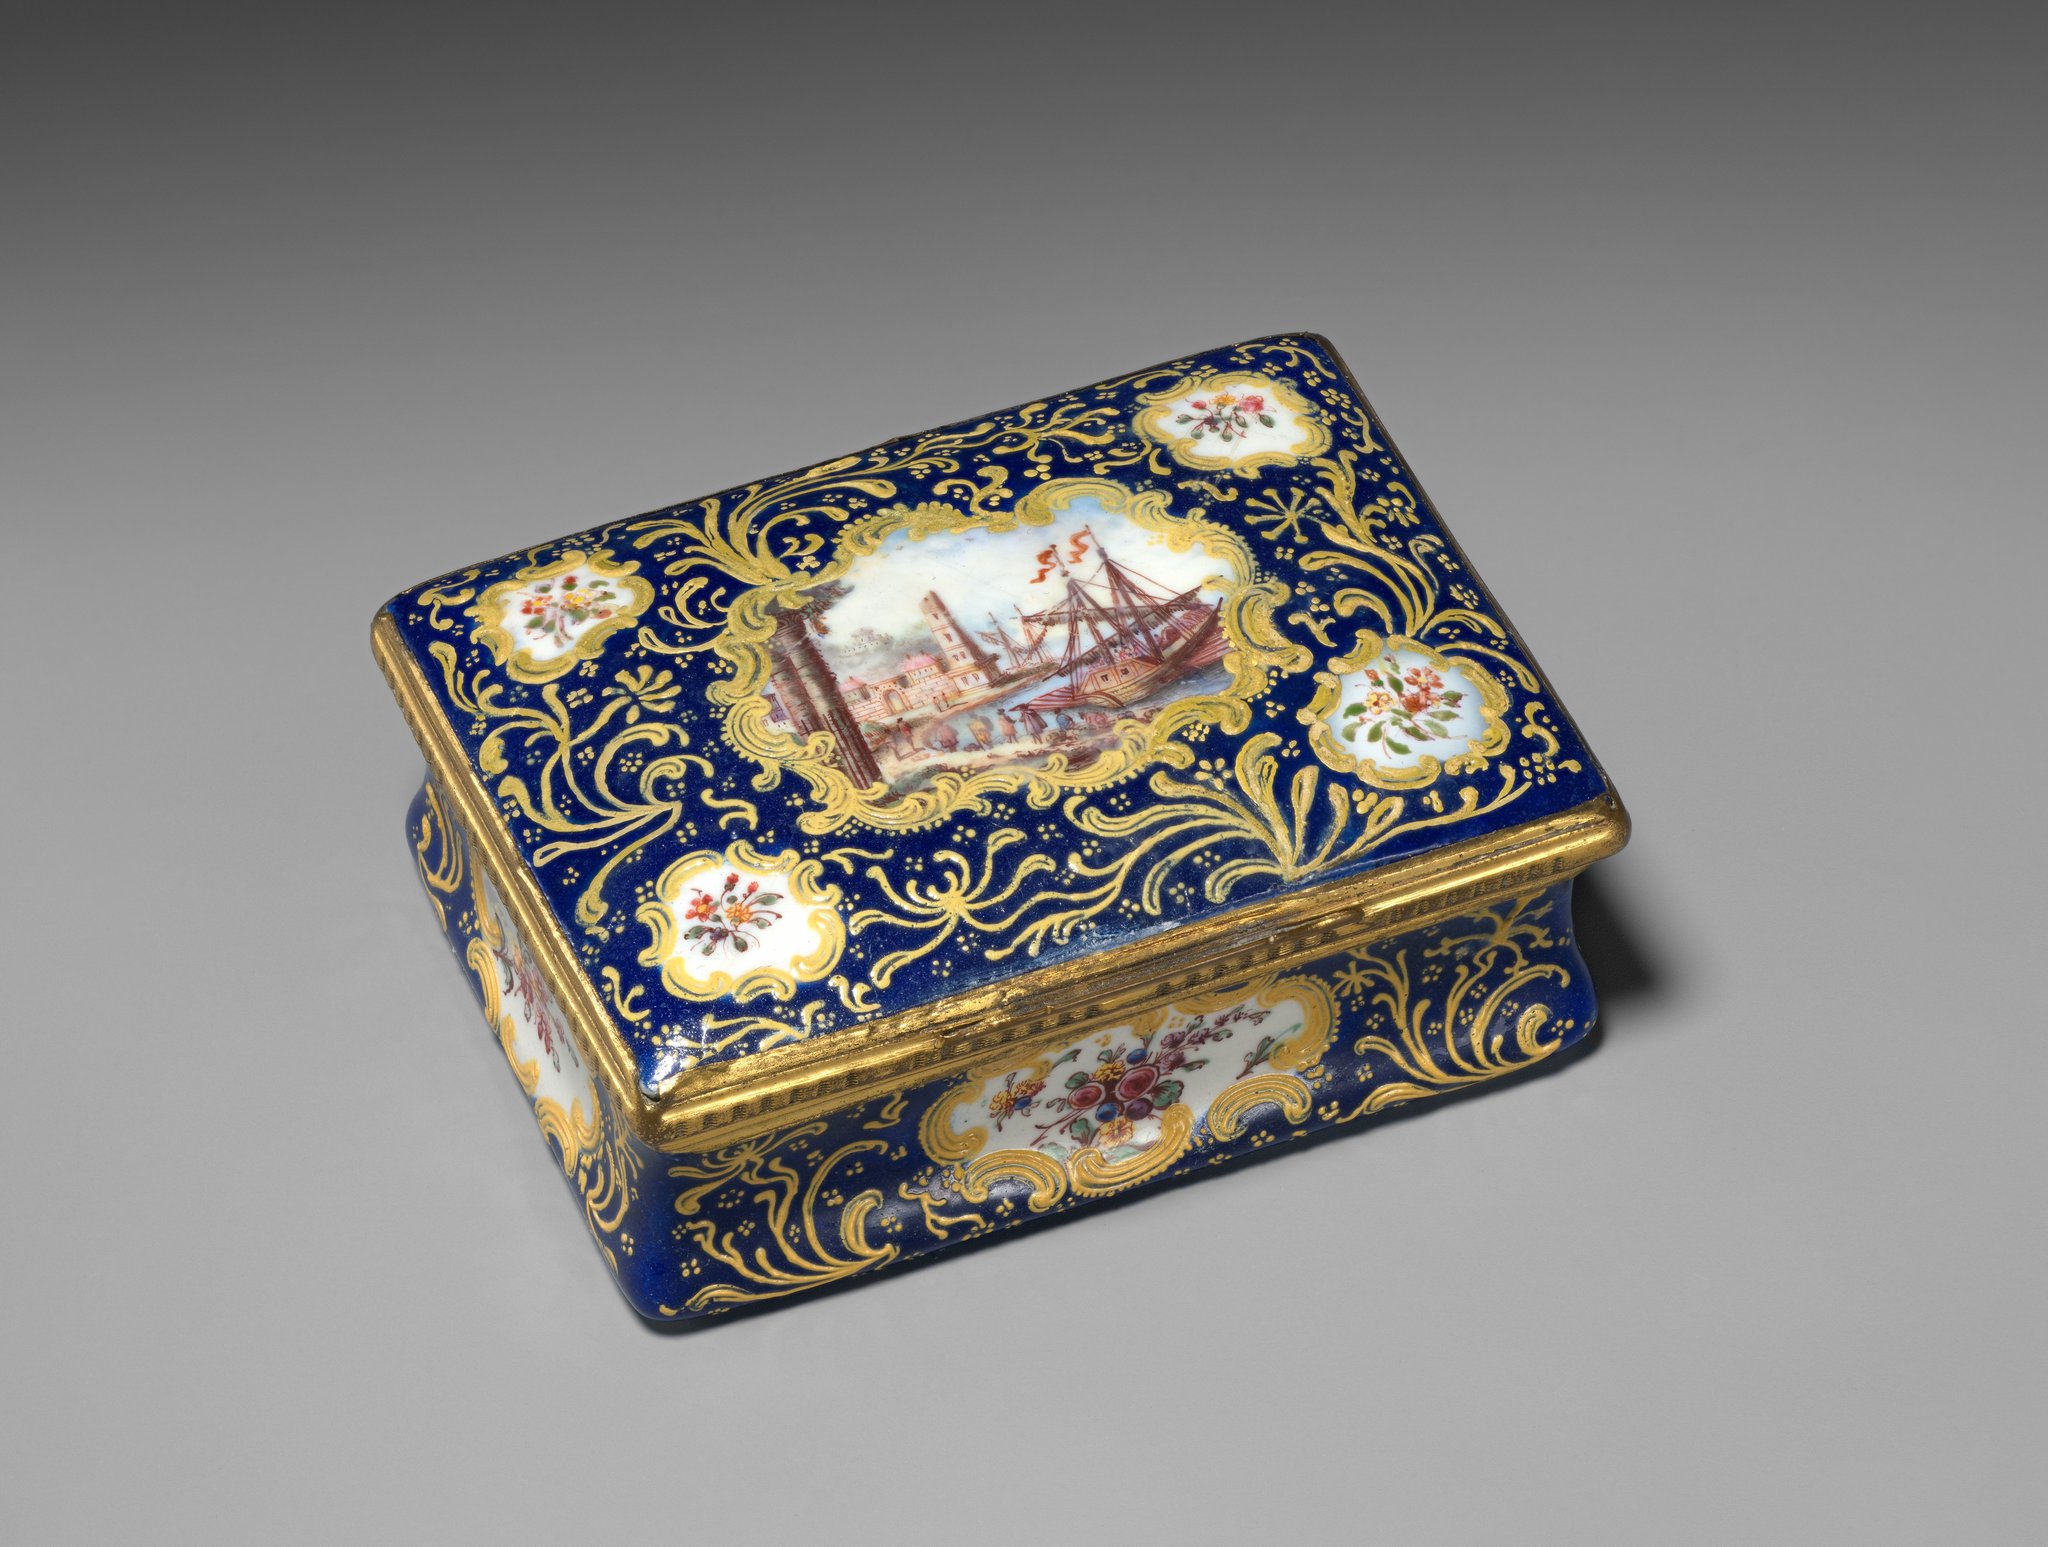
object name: snuffbox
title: Snuffbox from the so-called "Honeysuckle Group"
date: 1760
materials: copper, enamel